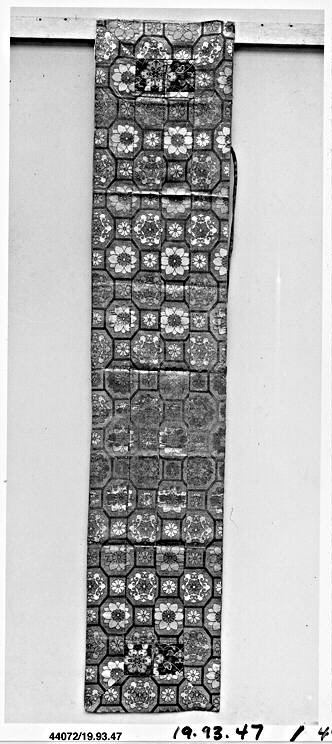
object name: stole, priest's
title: Priest's Stole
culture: japanese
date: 1401-1500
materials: metal thread, silk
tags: flowers